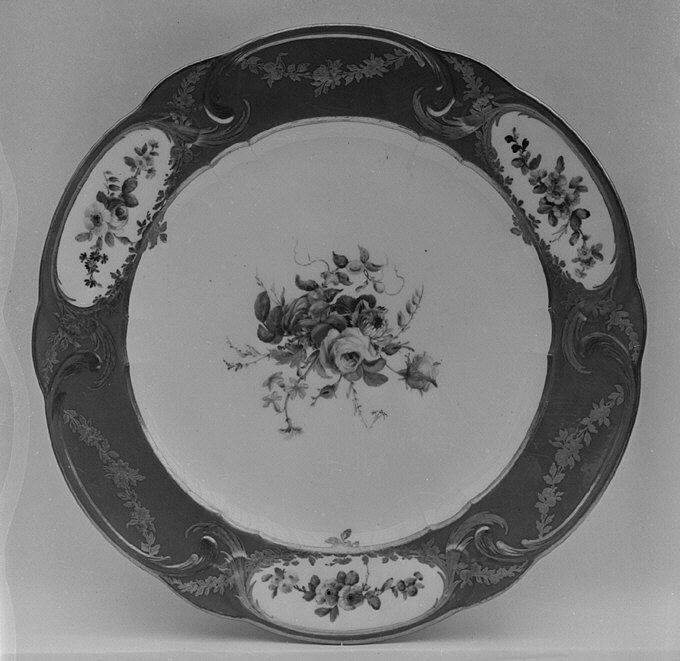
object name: plate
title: Plate (assiette à palmes) (1 of 102) (part of a service)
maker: sèvres manufactory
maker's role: manufactory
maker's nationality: french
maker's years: 1740-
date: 1772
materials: soft paste porcelain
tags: flowers